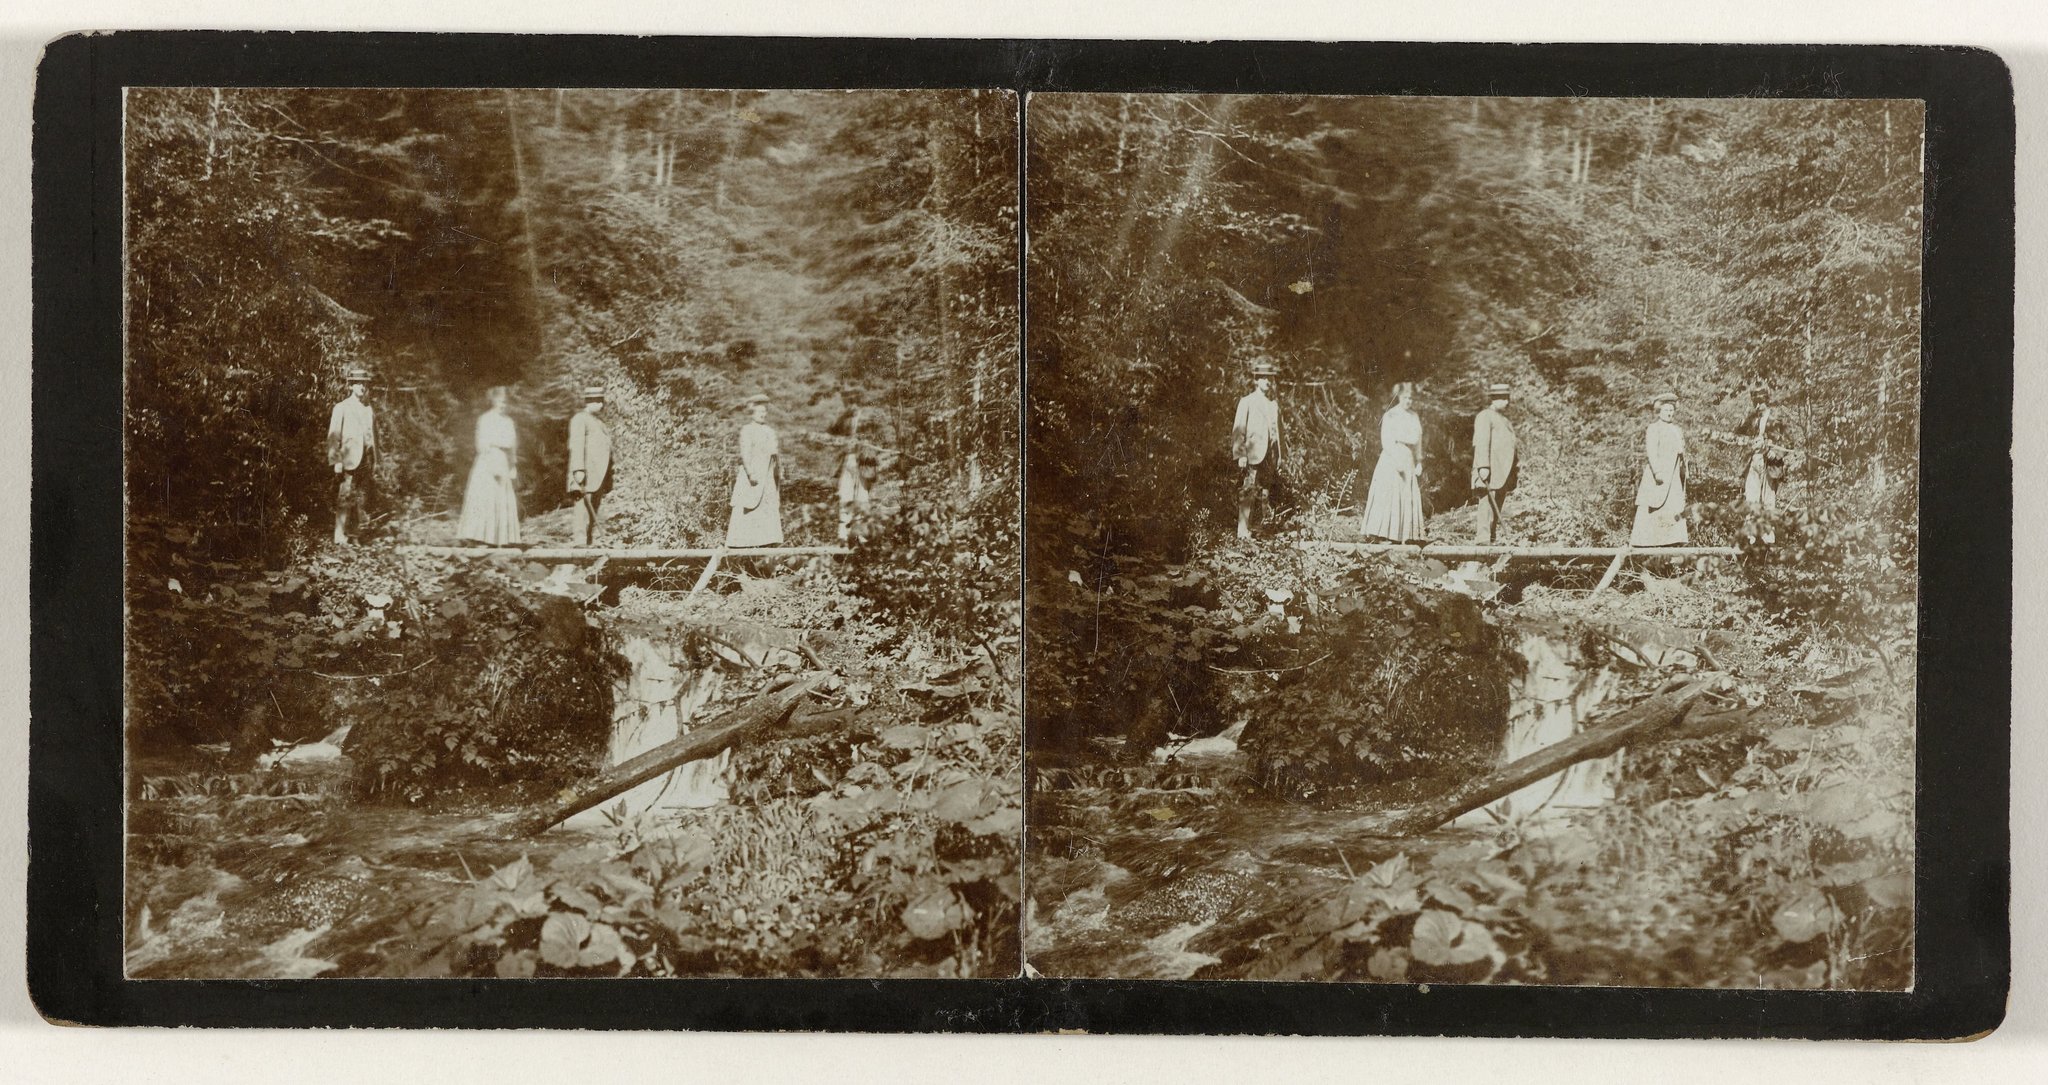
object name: stereograph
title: Brug over een beek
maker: geldolph adriaan kessler (dolph)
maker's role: fotograaf, industrieel, voetballer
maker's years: 1884-1945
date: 1895-1903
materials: paper, photographic support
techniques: collodion silver print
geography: netherlands